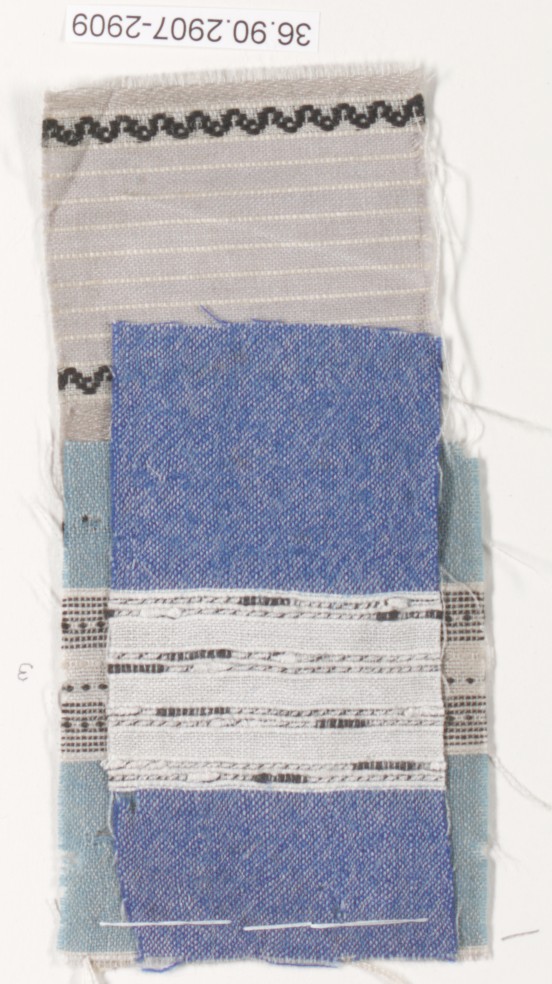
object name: piece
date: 1801-1900